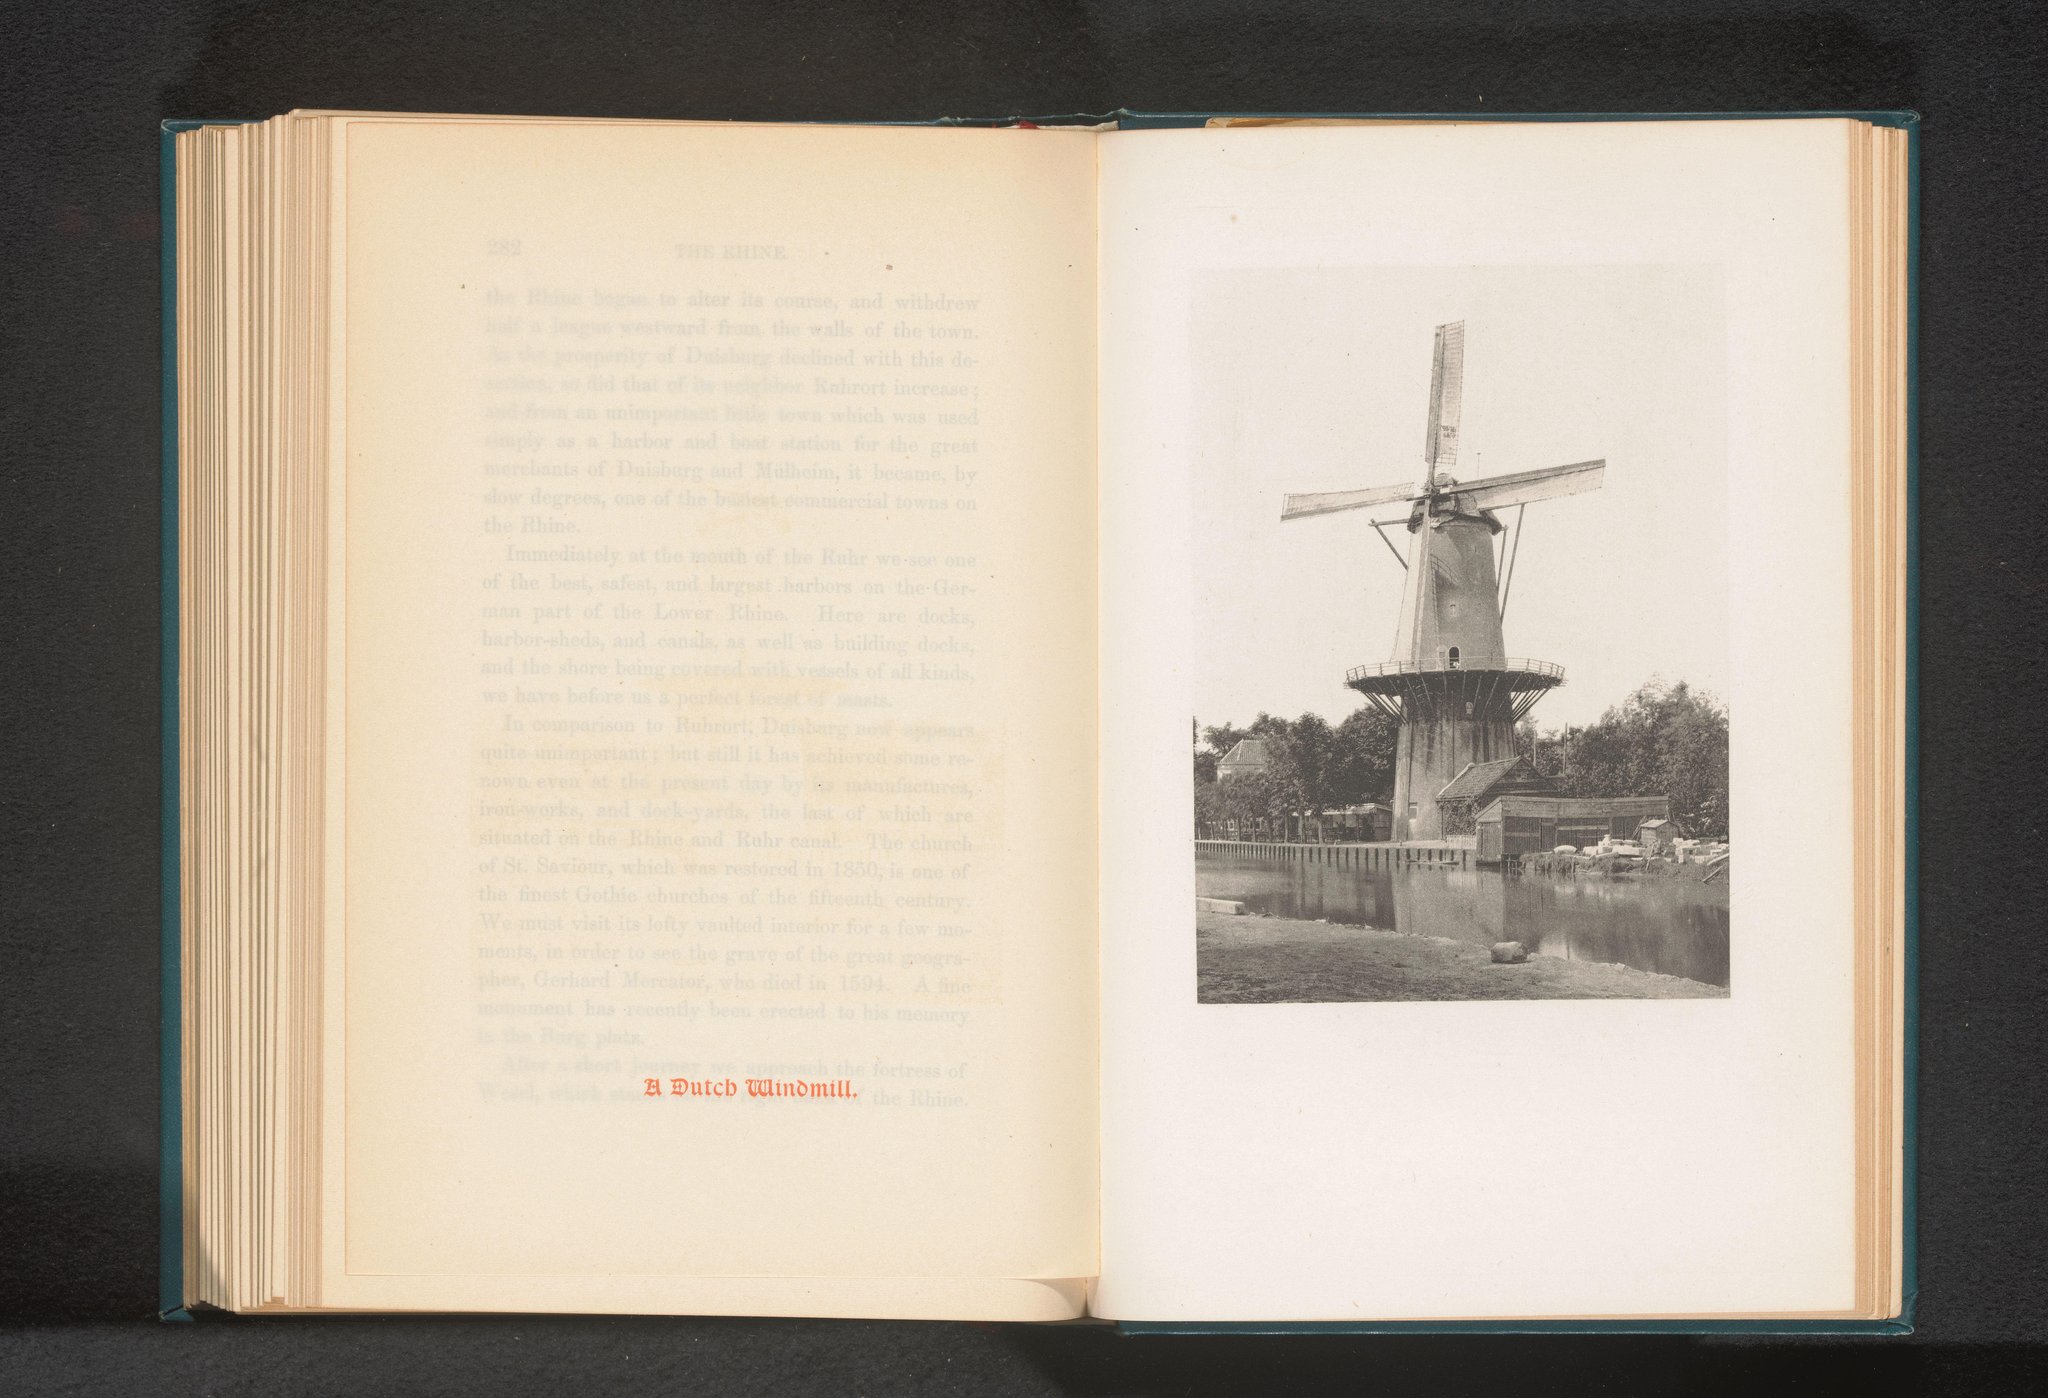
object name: photomechanical print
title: Exterieur van de Dom van Aken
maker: Anonymous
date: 1889-1899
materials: paper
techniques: photoaquatint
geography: aachen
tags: church (exterior), façade (of house or building)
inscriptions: title: ‘The Cathedral, Aix-la-Chapelle.’